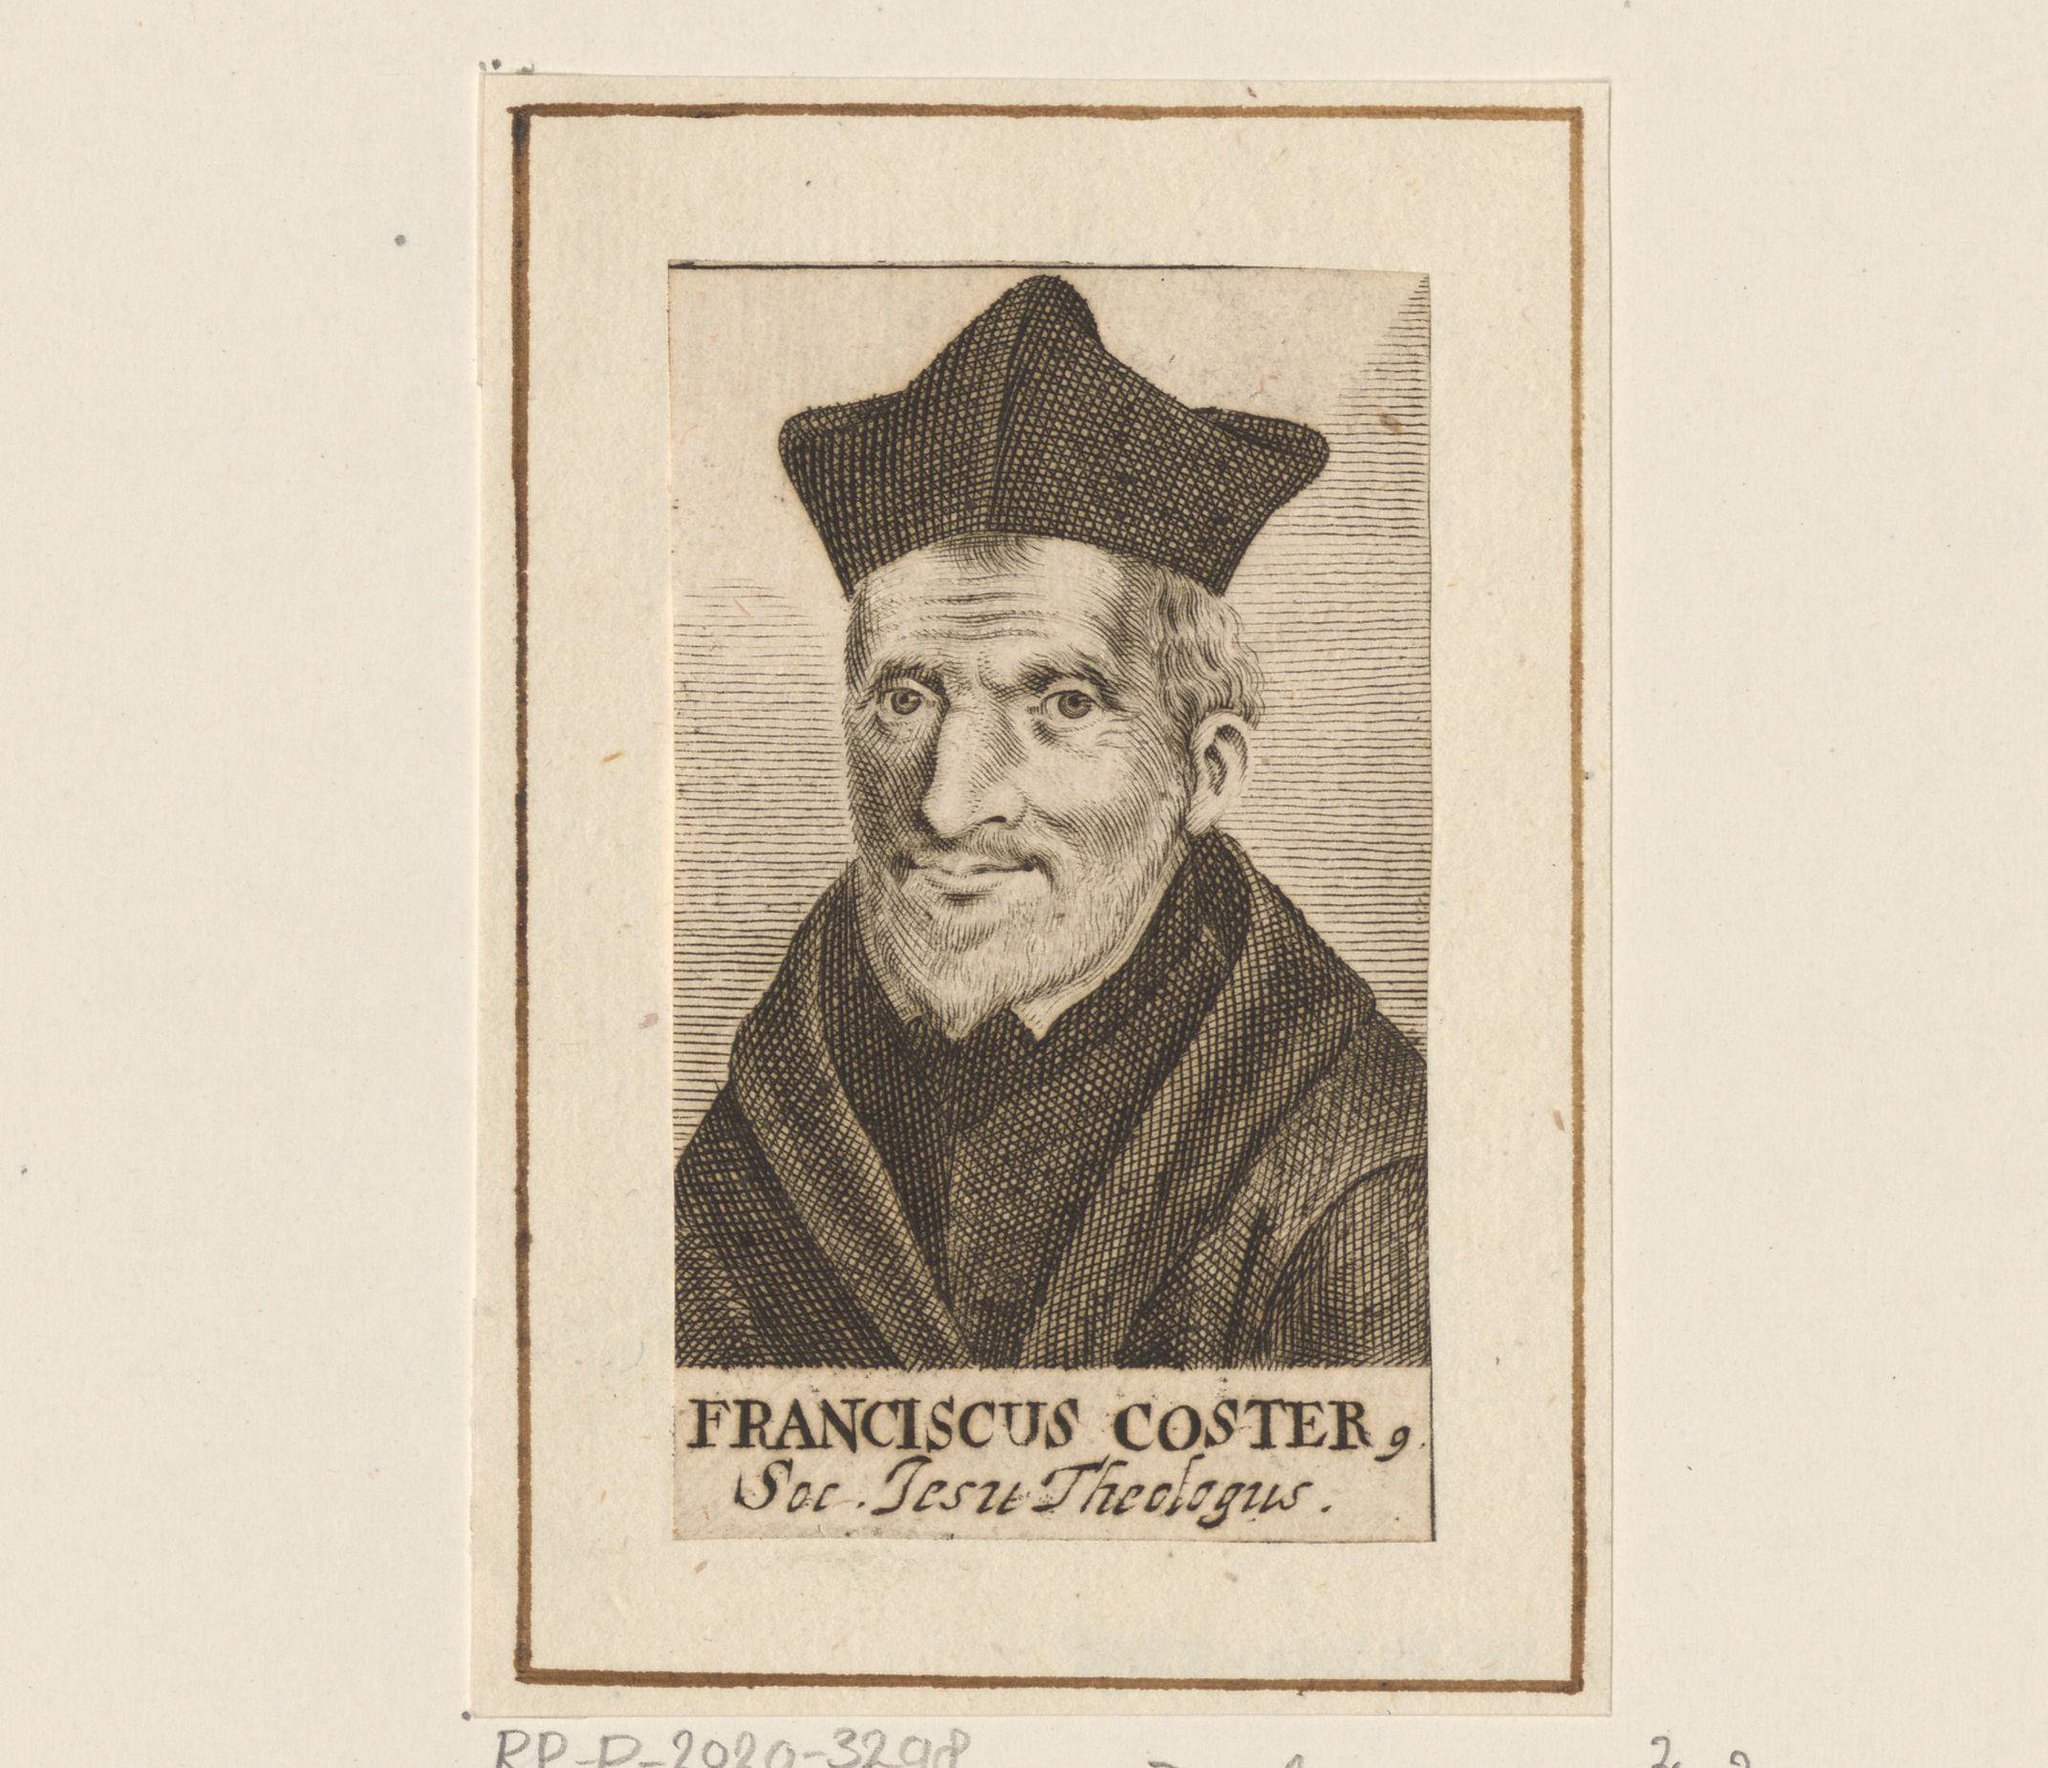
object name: print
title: Portret van Fransicus Costerus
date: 1688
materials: paper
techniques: engraving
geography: nuremberg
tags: mechelen, clergyman, historical persons, pope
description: Prent waarschijnlijk uit: Freher, Paul. Theatrum virorum eruditione clarorum. Neurenberg: Johann Hoffmann, 1688.